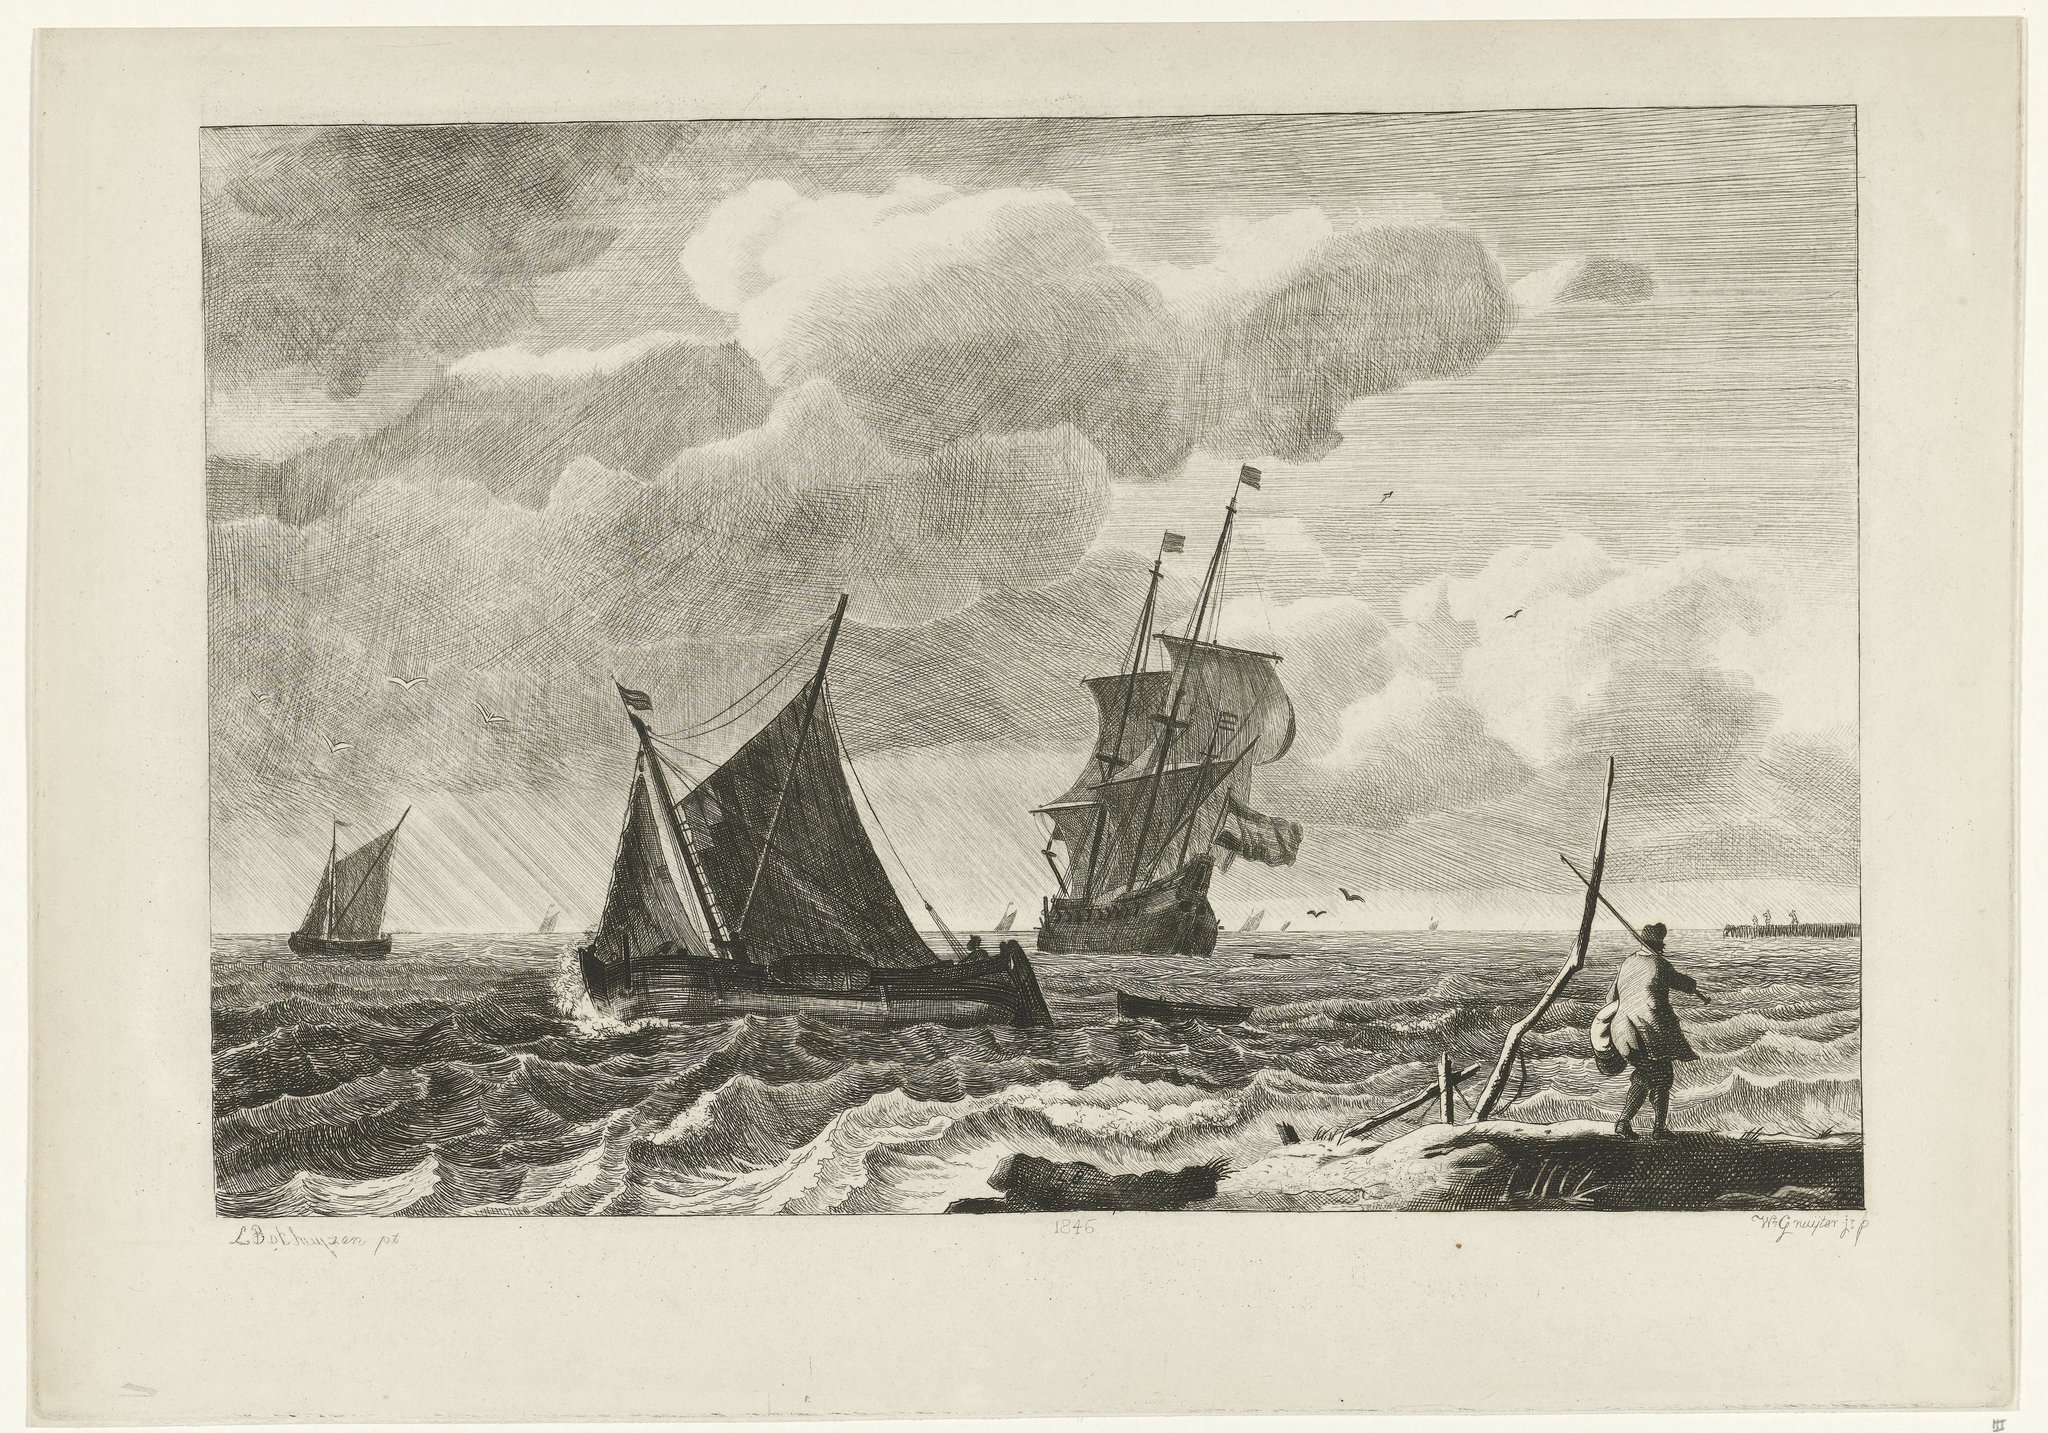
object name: print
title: Zeegezicht met zeilschepen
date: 1846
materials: paper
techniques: engraving, etching, roulette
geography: amsterdam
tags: sailing-ship, sailing-boat (+ view ~ vehicle, ship, etc.)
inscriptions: collector's mark: Lugt 2165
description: Zeegezicht met enkele zeilschepen, waaronder een tweemaster, bij sterke wind. Rechts op de voorgrond een man met een stok over zijn schouder. Op rots middenvoor staan de initialen van de schilder. Prent naar een schilderij van Ludolf Bakhuysen.